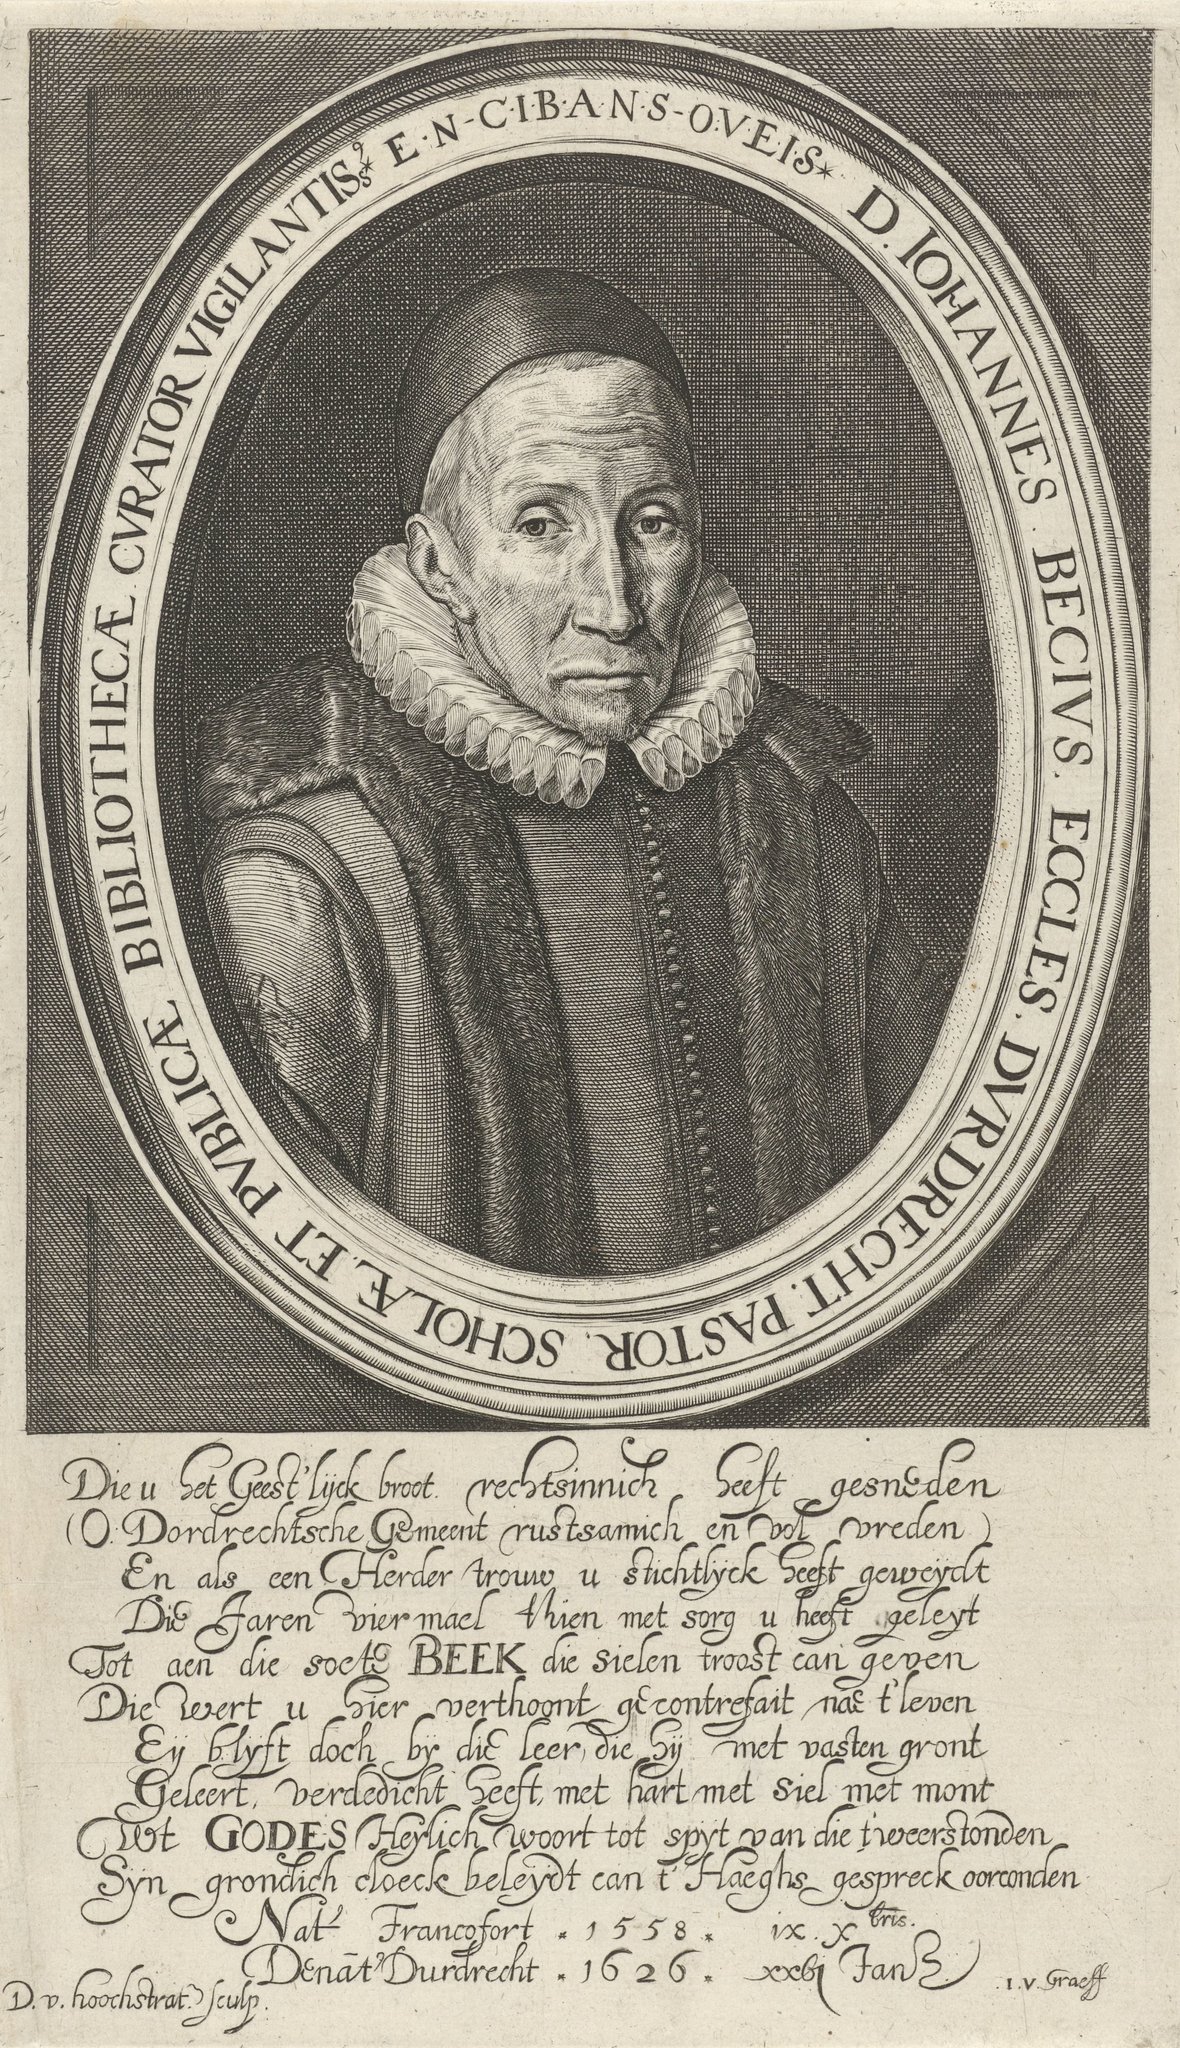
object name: print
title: Portret van Johannes Becius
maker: i.v. graeff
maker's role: schrijver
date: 1626-1640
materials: paper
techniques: engraving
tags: dordrecht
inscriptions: collector's mark: Lugt 2760, collector's mark: Lugt 2228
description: Portret van Johannes Becius, predikant te Dordrecht.